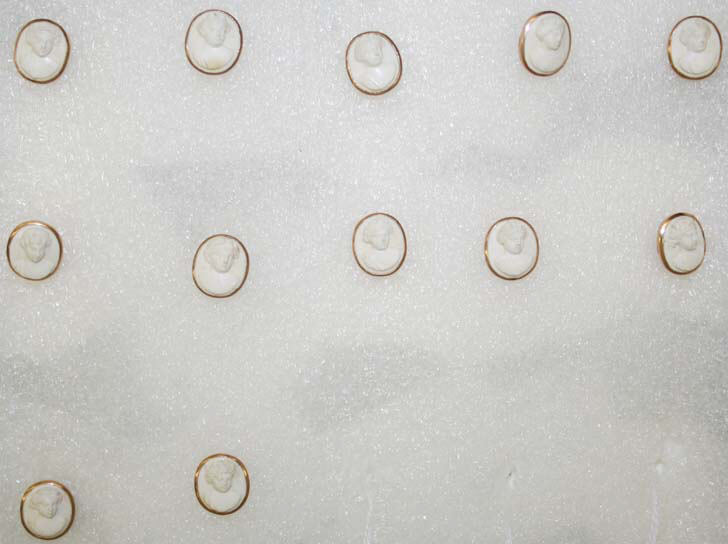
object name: button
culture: italian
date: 1880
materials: metal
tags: cameos,women